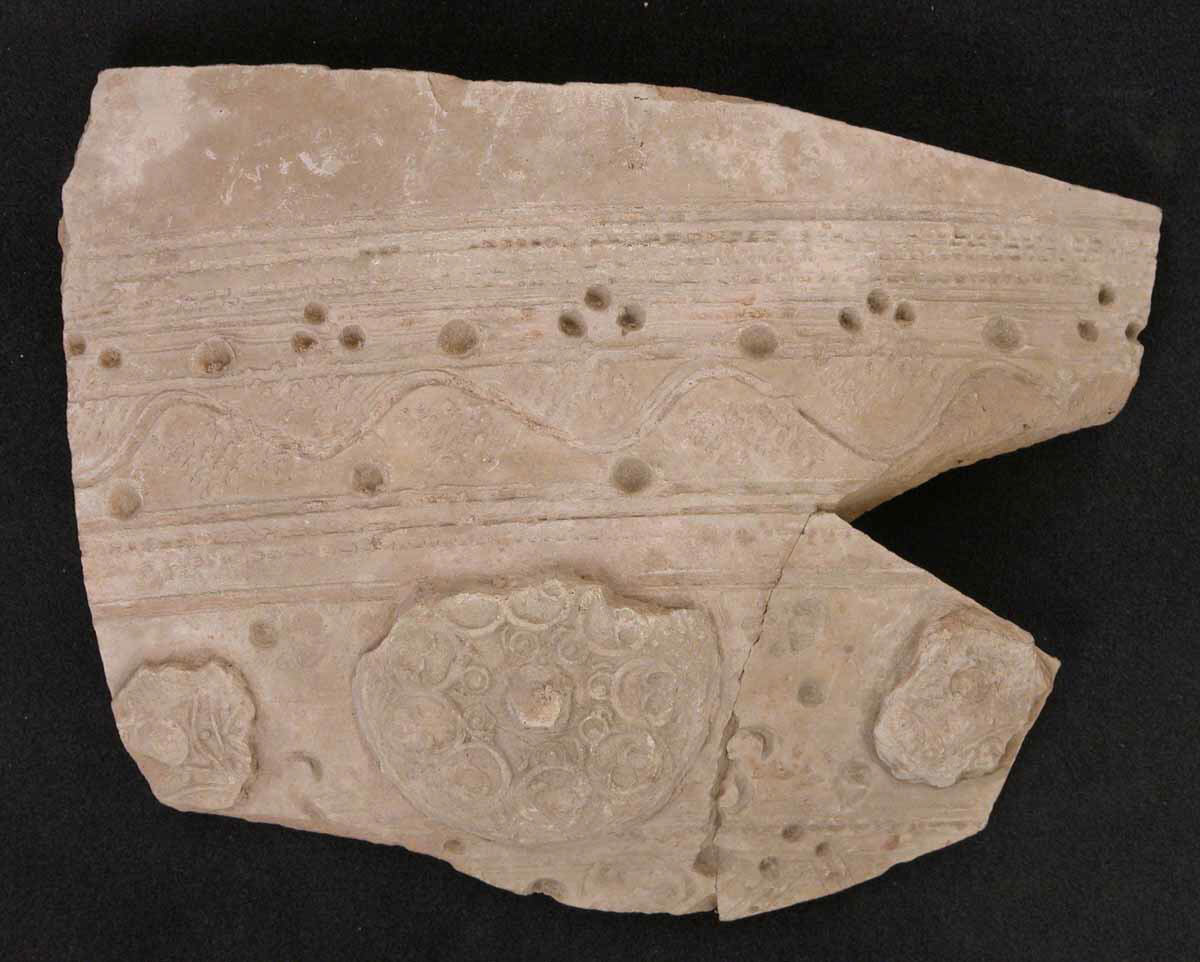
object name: fragment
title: Fragment of Jar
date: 901-1100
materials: earthenware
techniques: incising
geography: iran